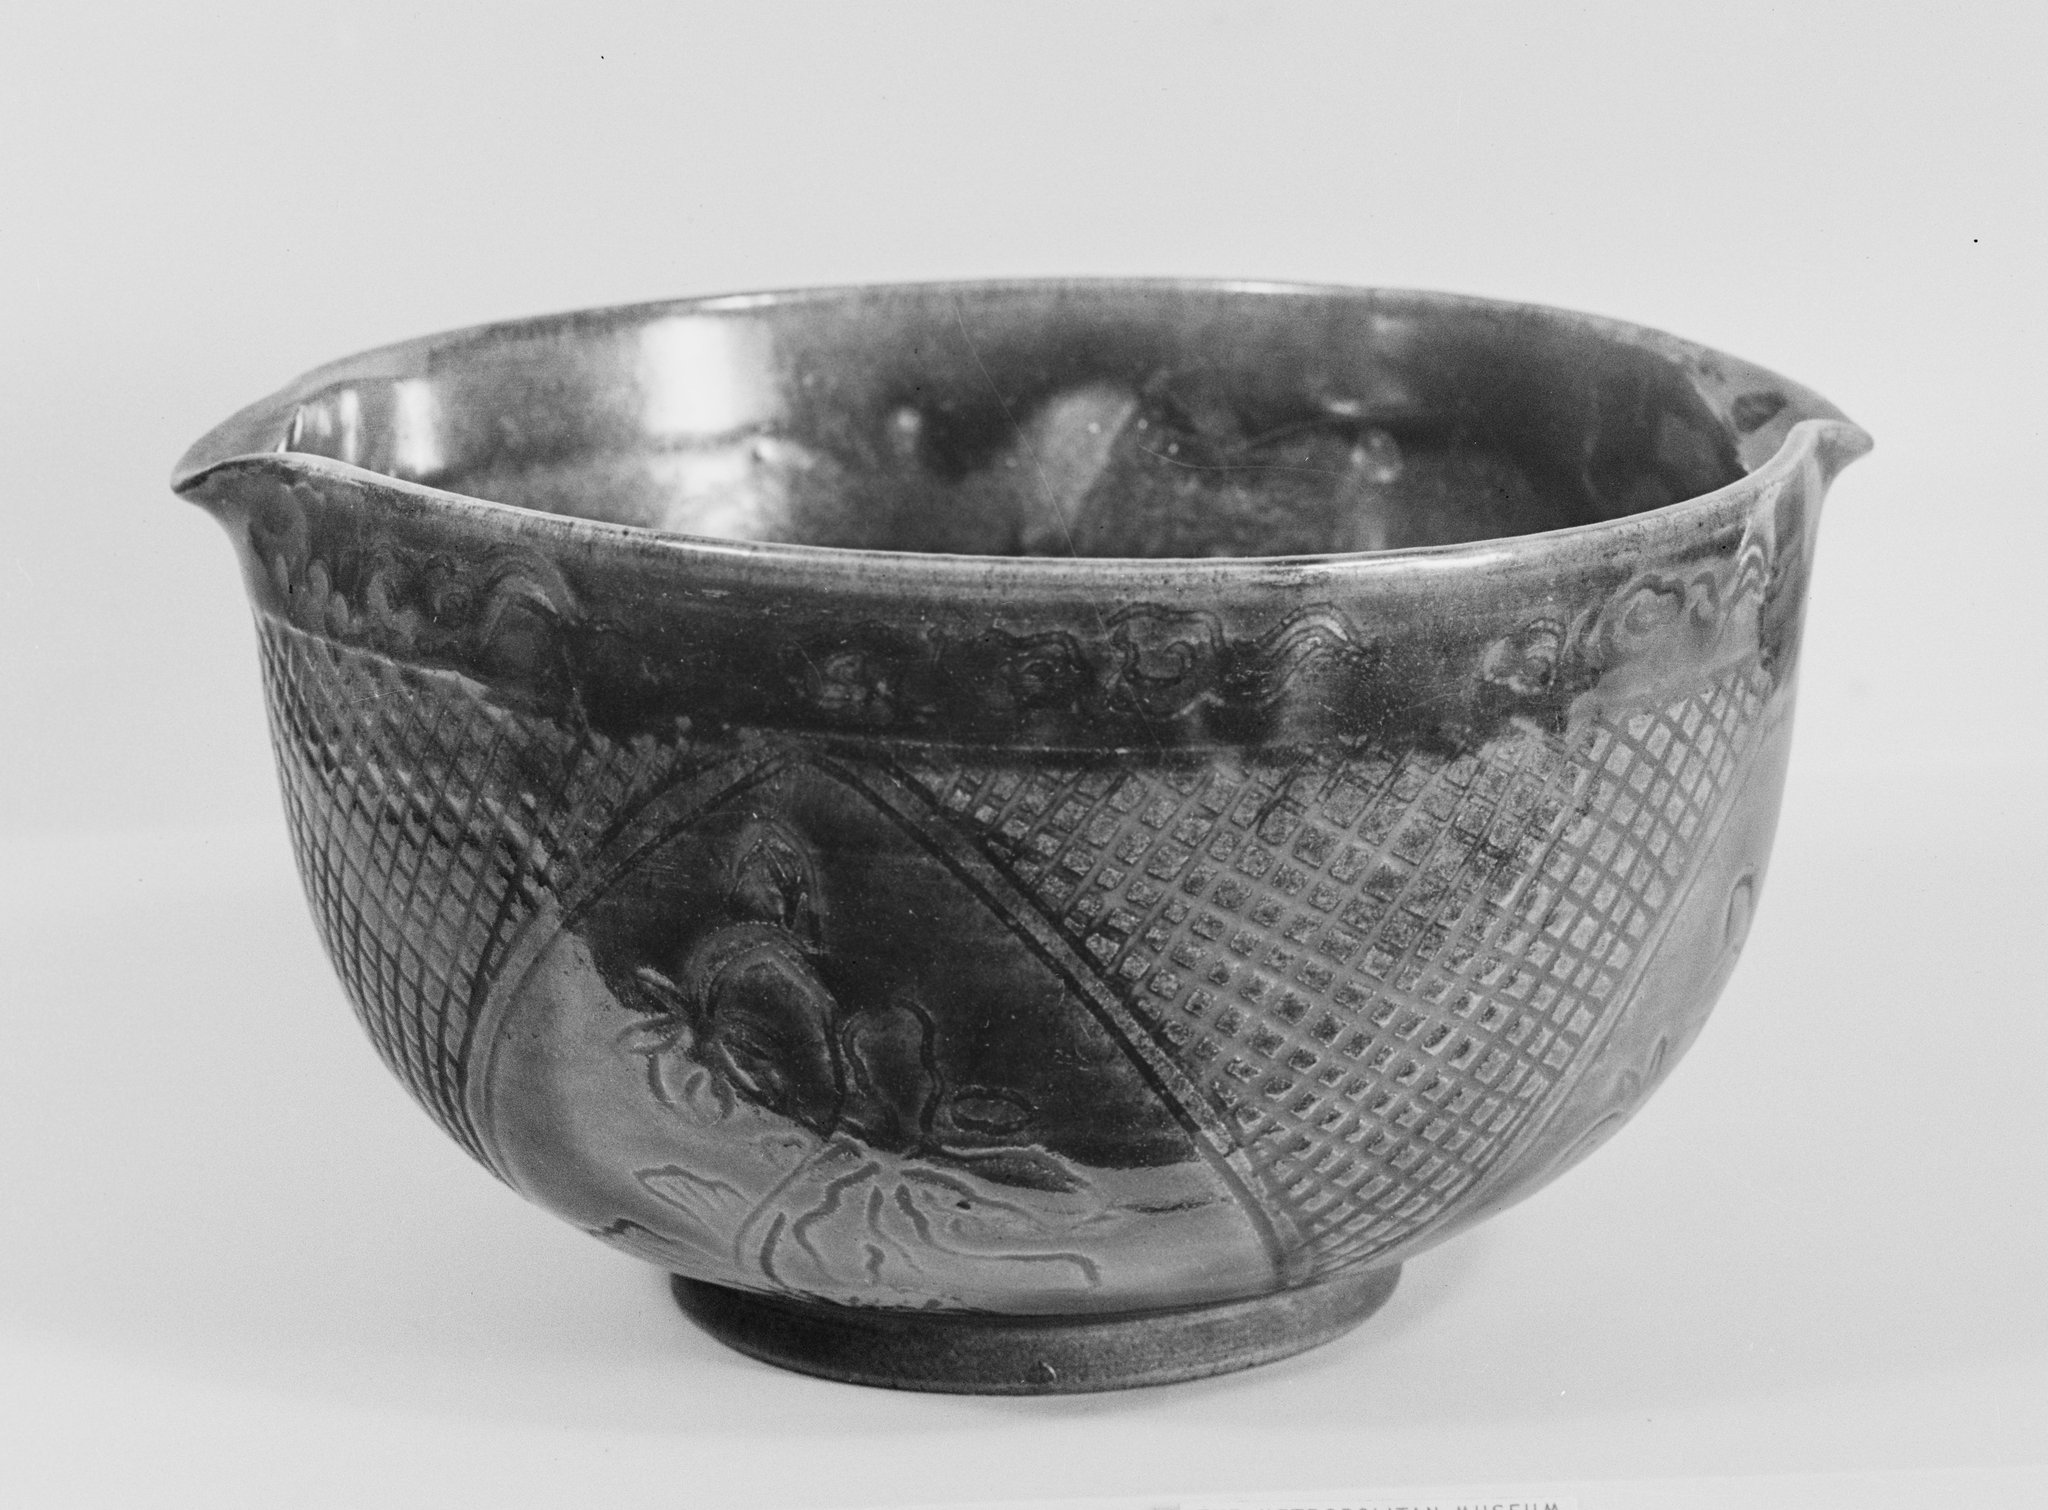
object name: bowl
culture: japanese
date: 1801-1900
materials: clay, glaze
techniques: incising